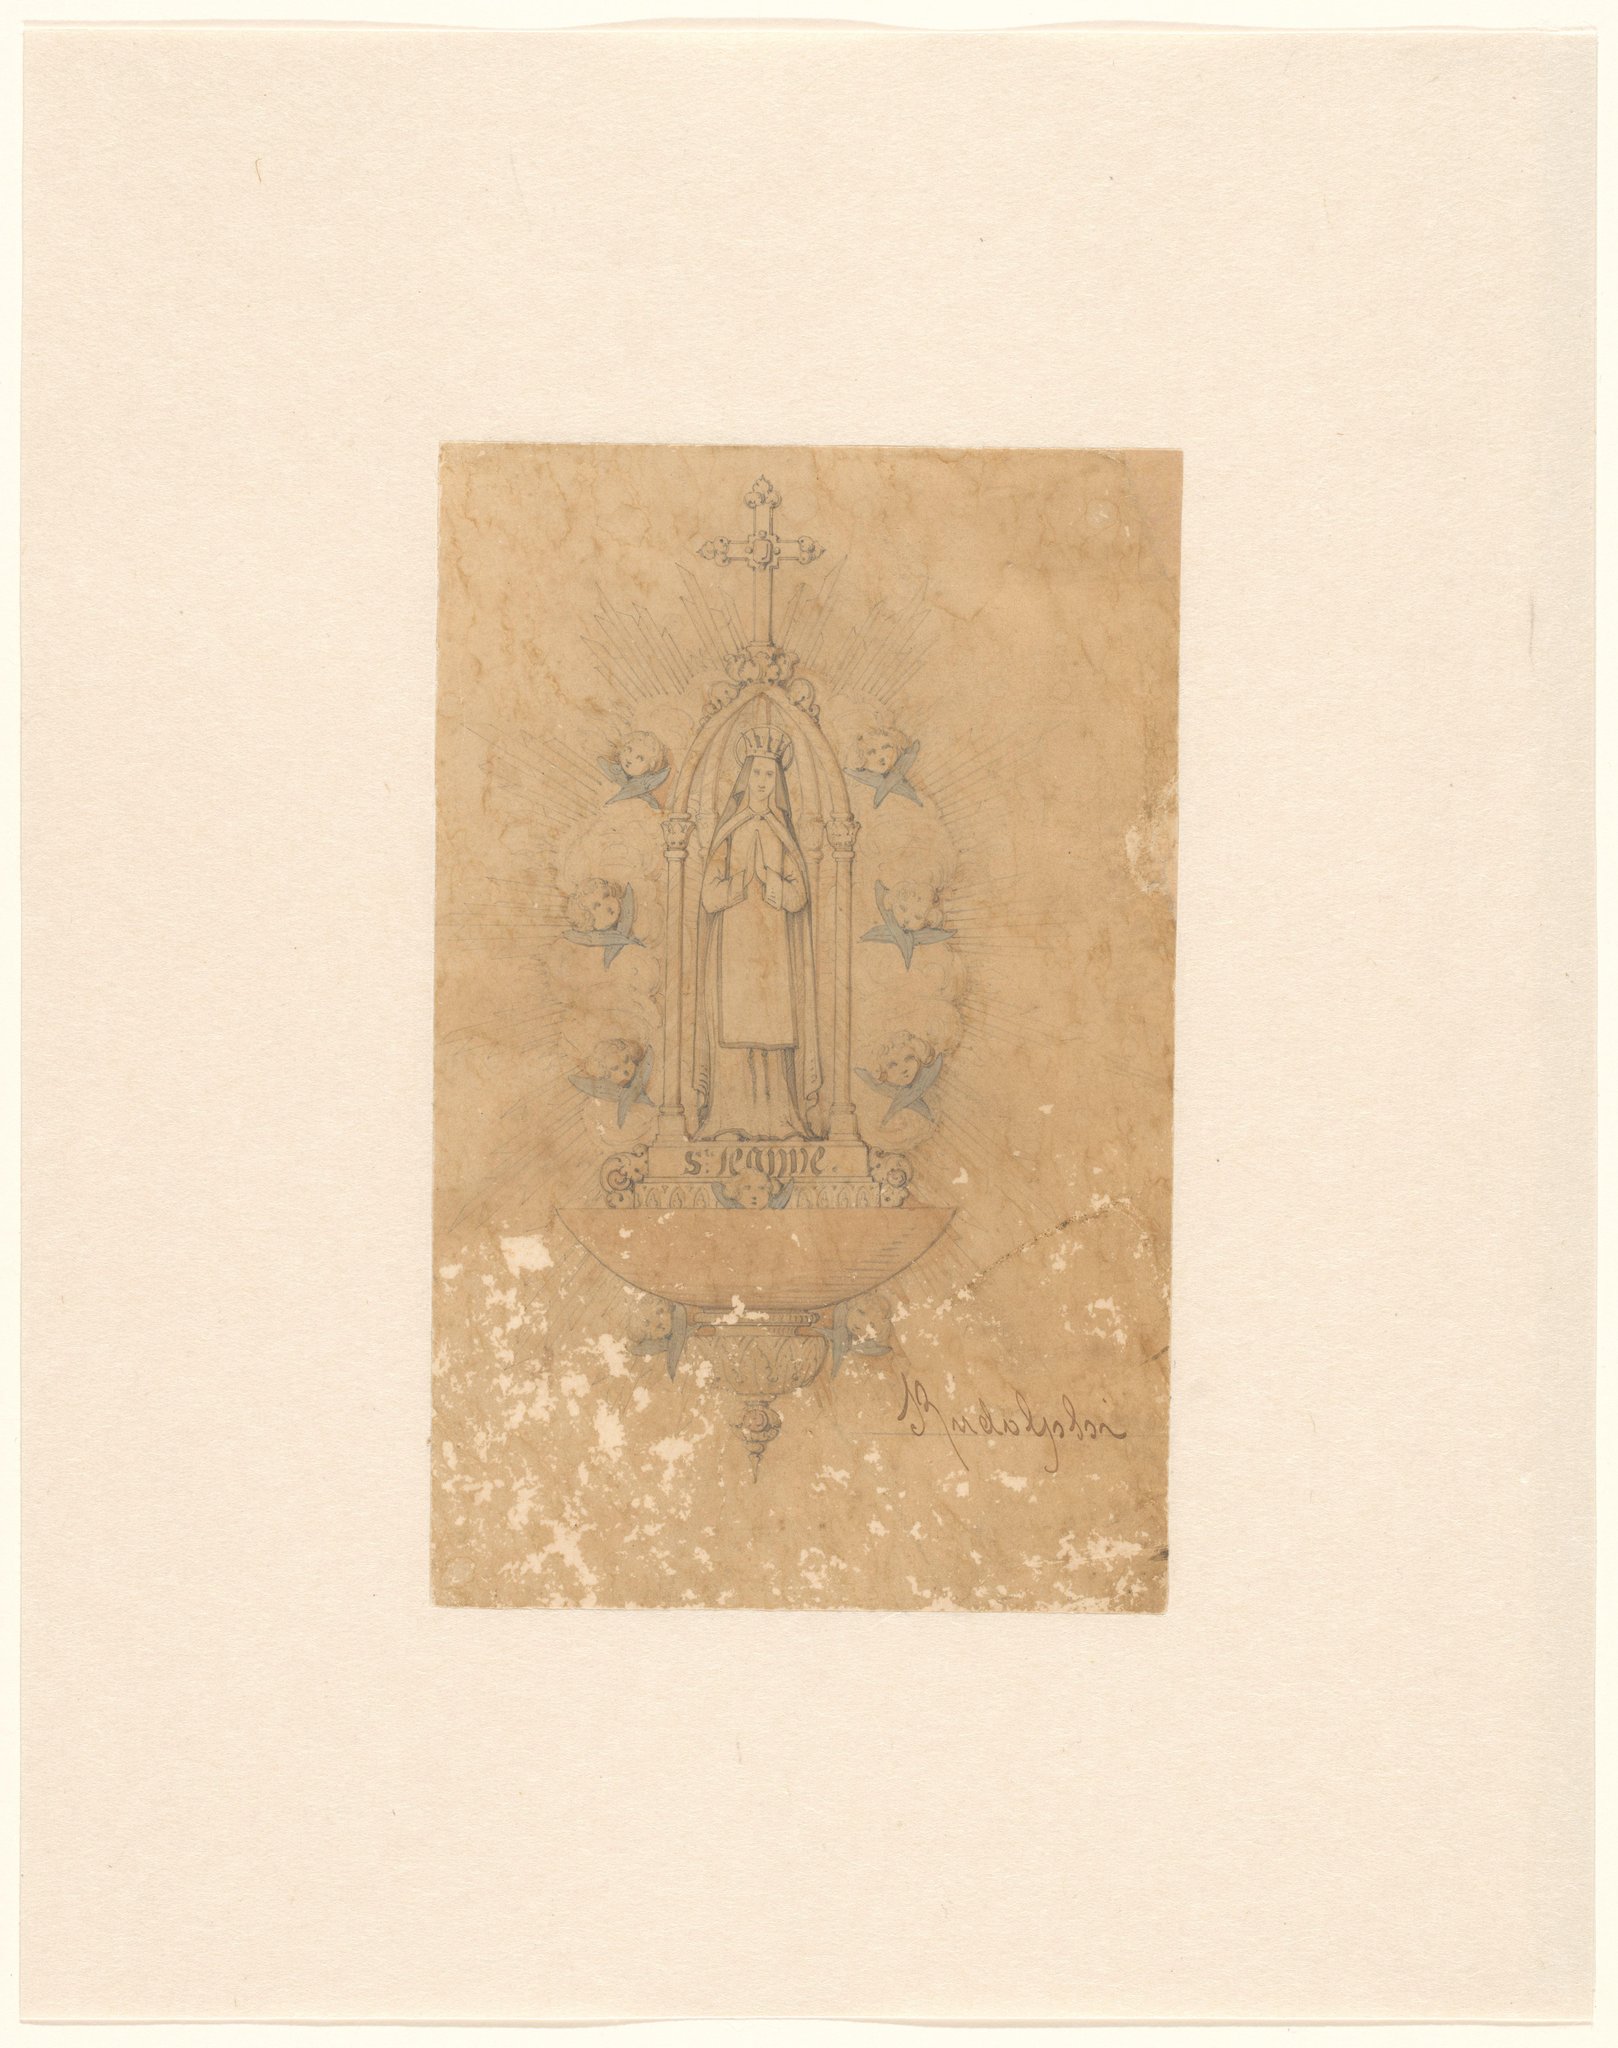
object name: design drawing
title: Ontwerp voor een wijwatervat (?)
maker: frédéric-jules rudolphi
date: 1845-1855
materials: cardboard, graphite, paper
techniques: brush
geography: paris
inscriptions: signature: ‘Rudolphi’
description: Vat met Jeanne d’Arc temidden van cherubijnen, met het opschrift: S.te JEANNE.